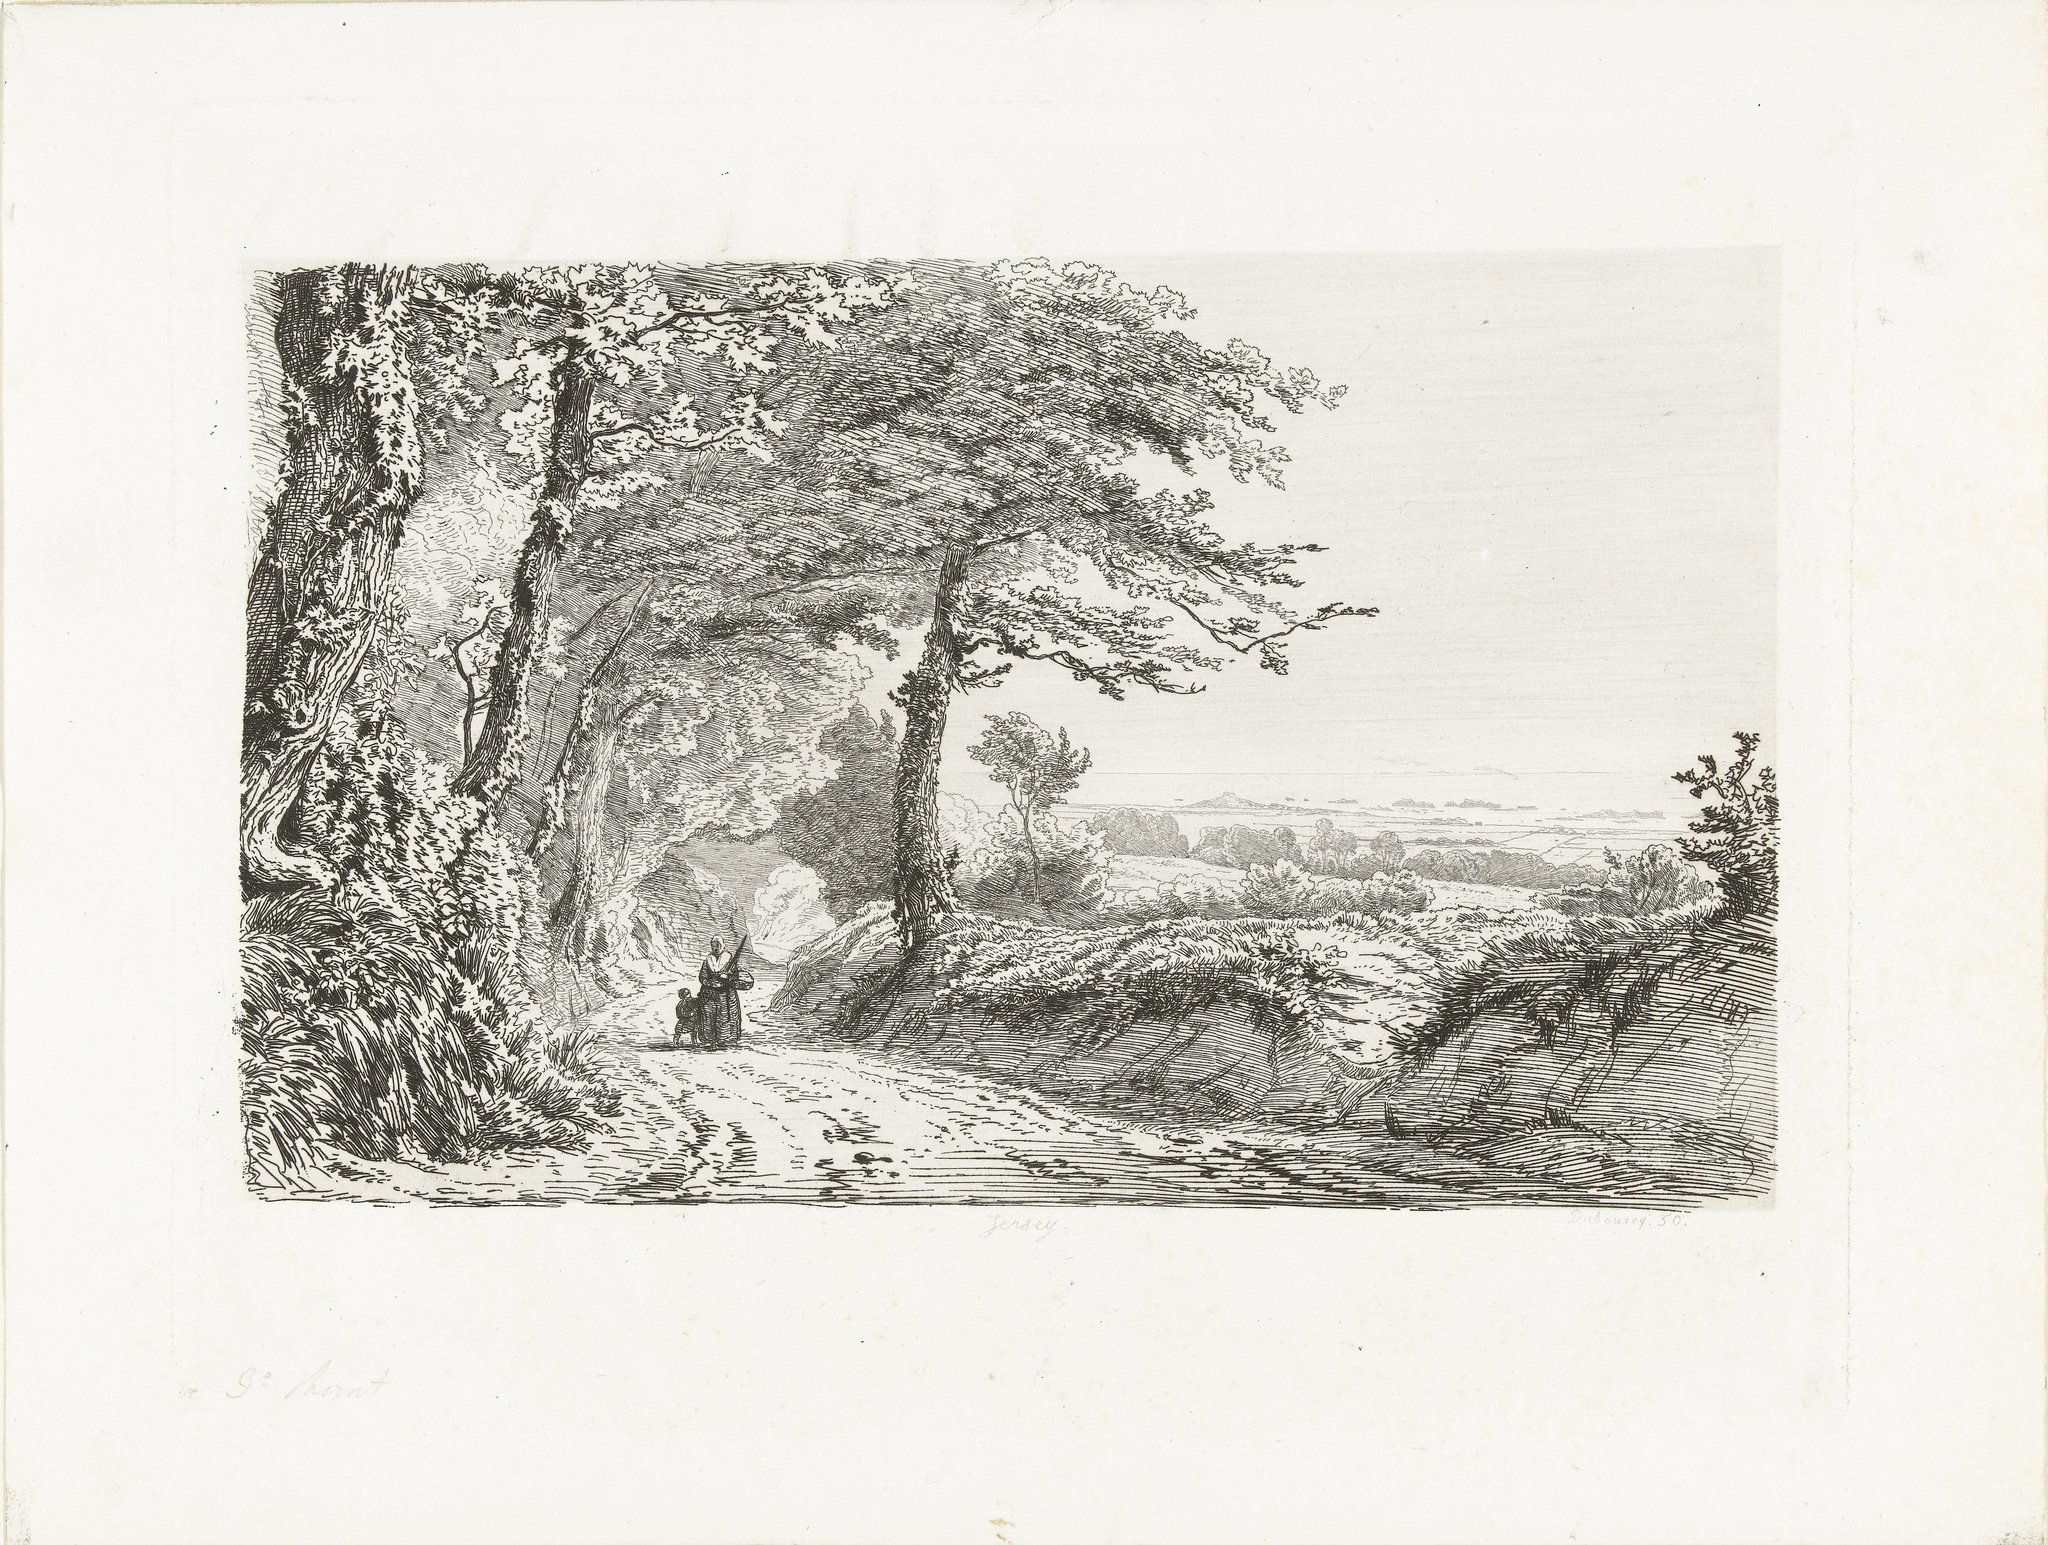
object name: print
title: Jersey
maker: pierre louis dubourcq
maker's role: draughtsman, painter, print maker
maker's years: 1815-1873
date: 1850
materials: paper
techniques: etching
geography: netherlands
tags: forest path or lane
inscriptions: collector's mark: Lugt 2228